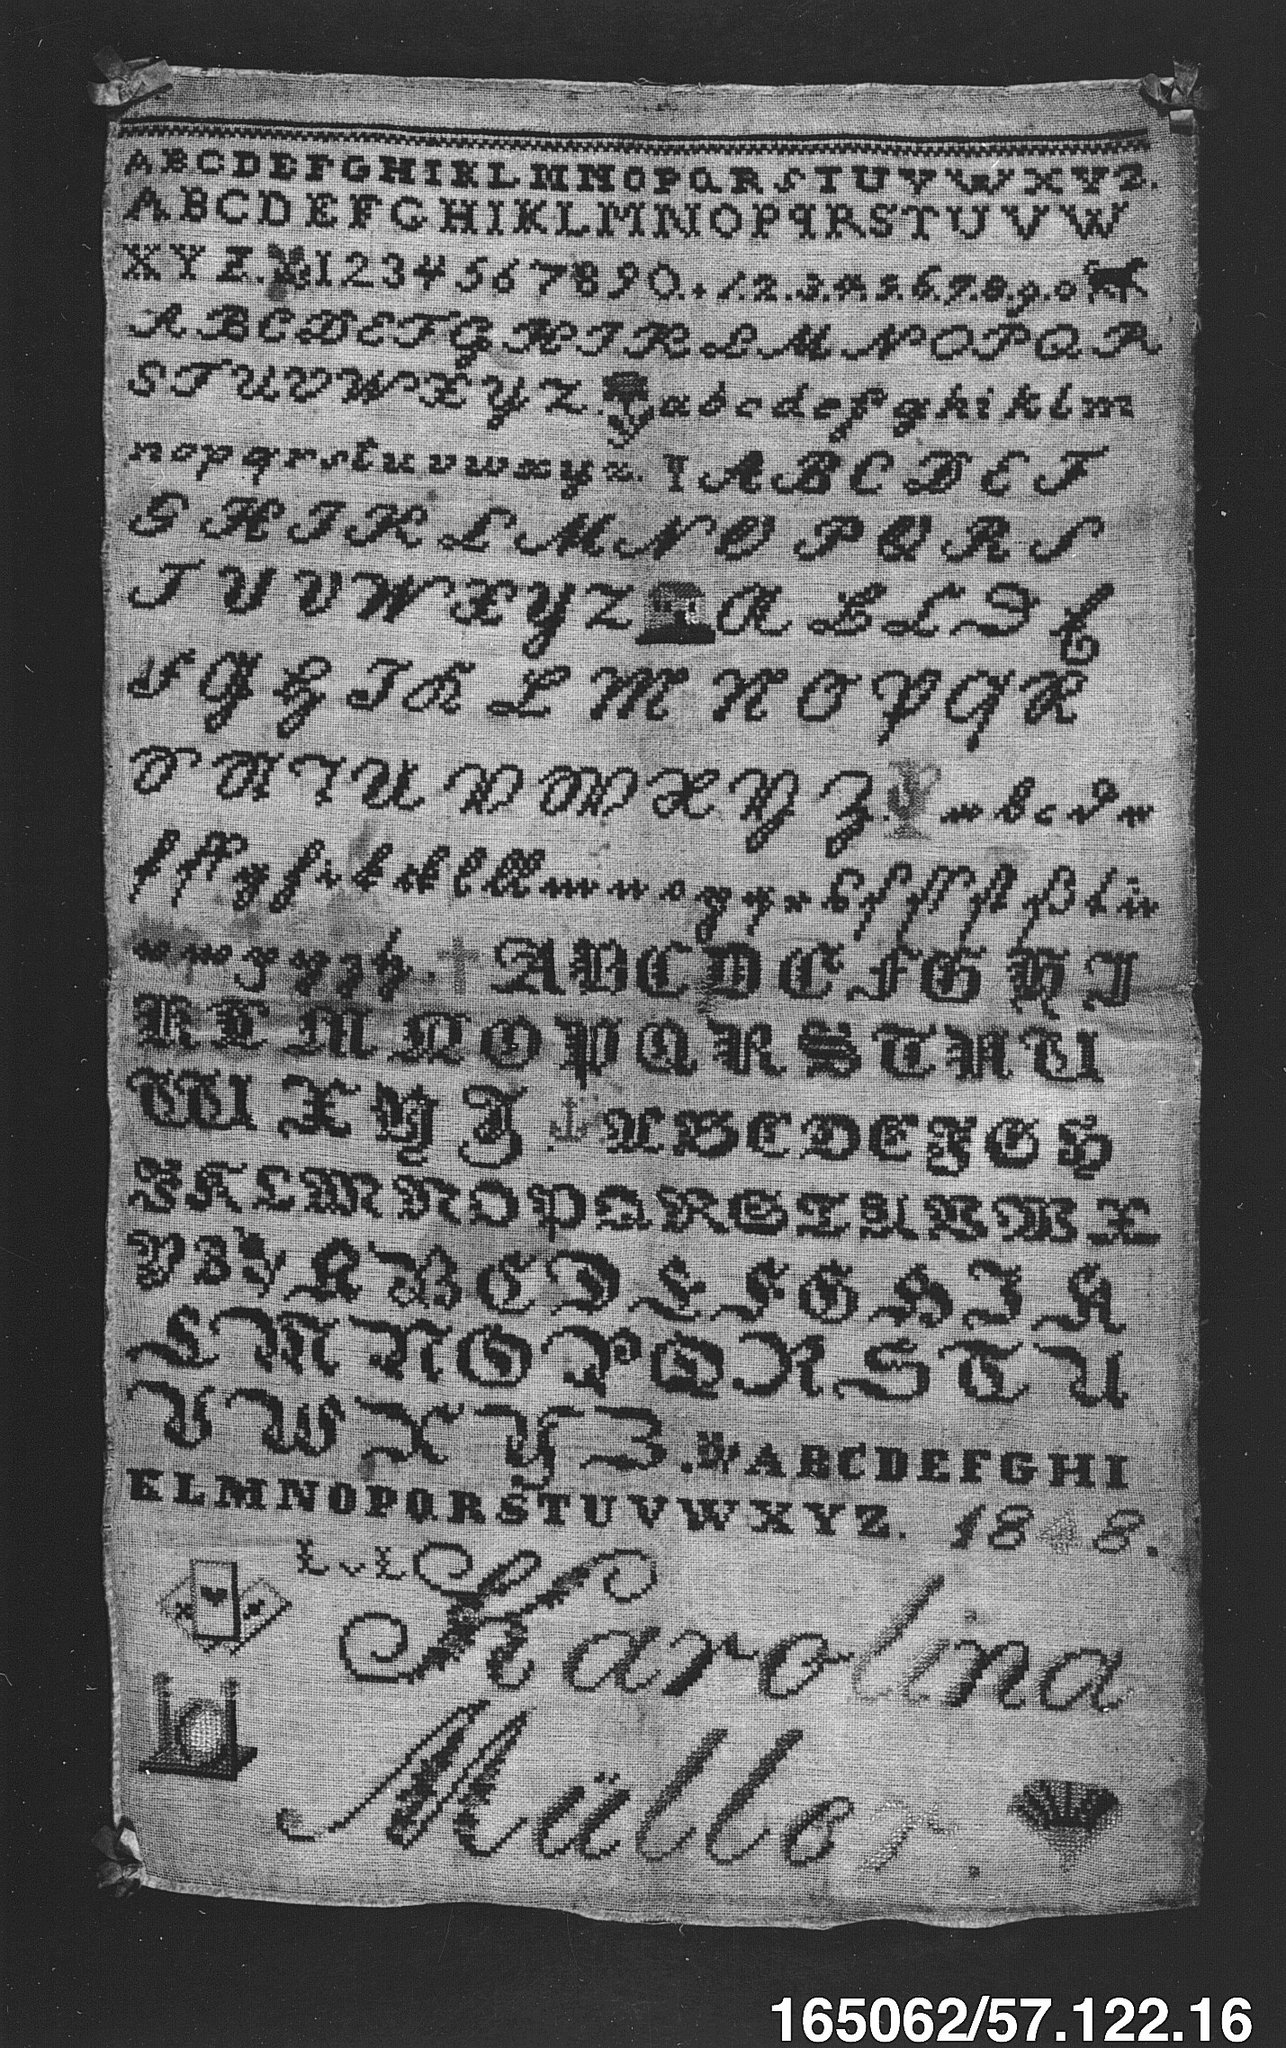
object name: sampler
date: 1848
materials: canvas, silk